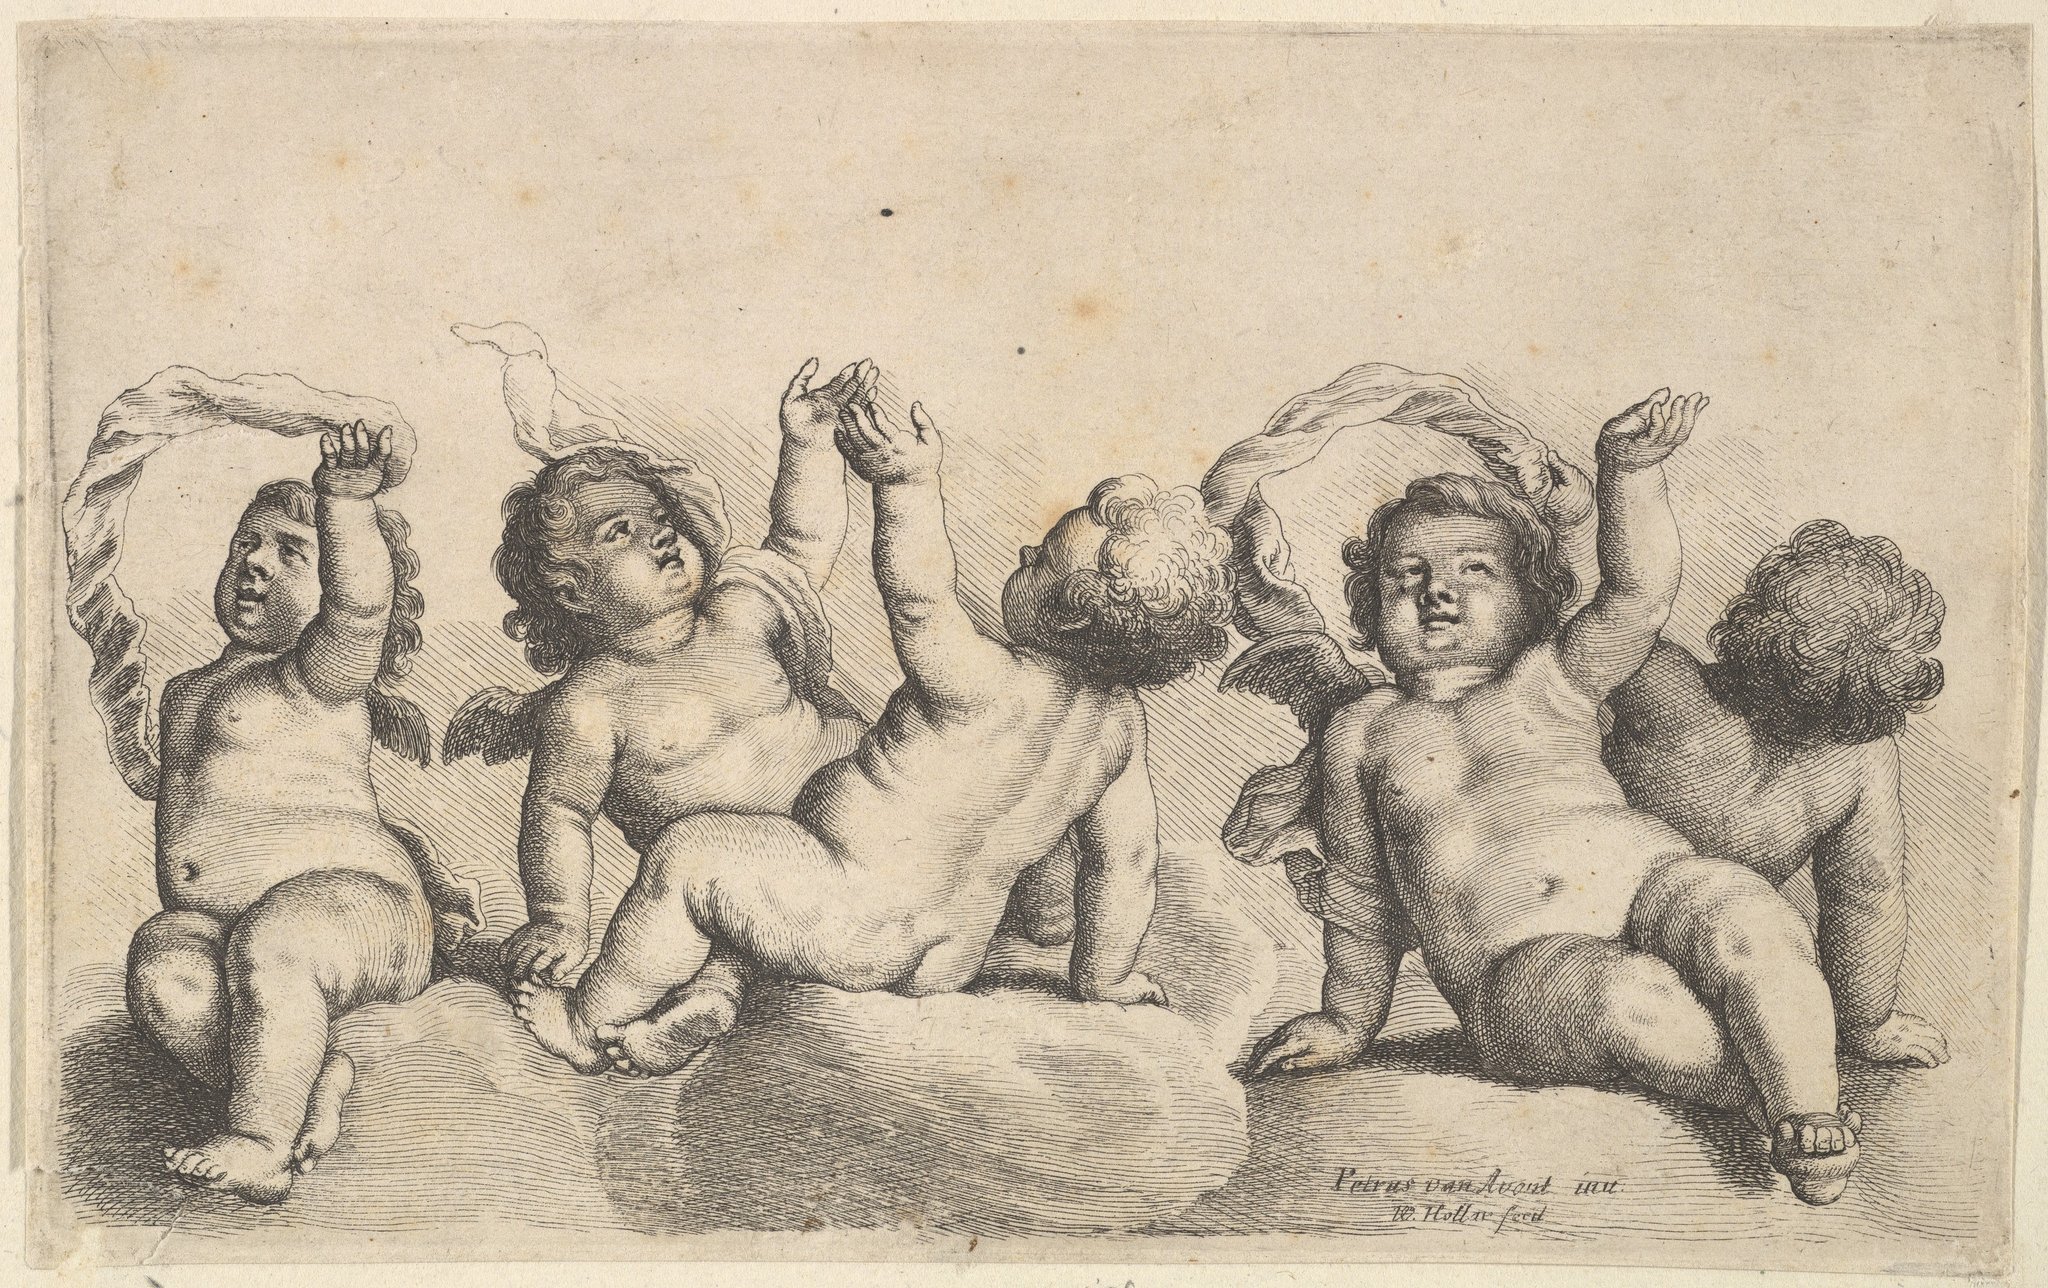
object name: print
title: Three cherubs and two boys on clouds, each raising one arm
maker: wenceslaus hollar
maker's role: artist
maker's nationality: bohemian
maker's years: 1607-1677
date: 1646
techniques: etching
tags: boys